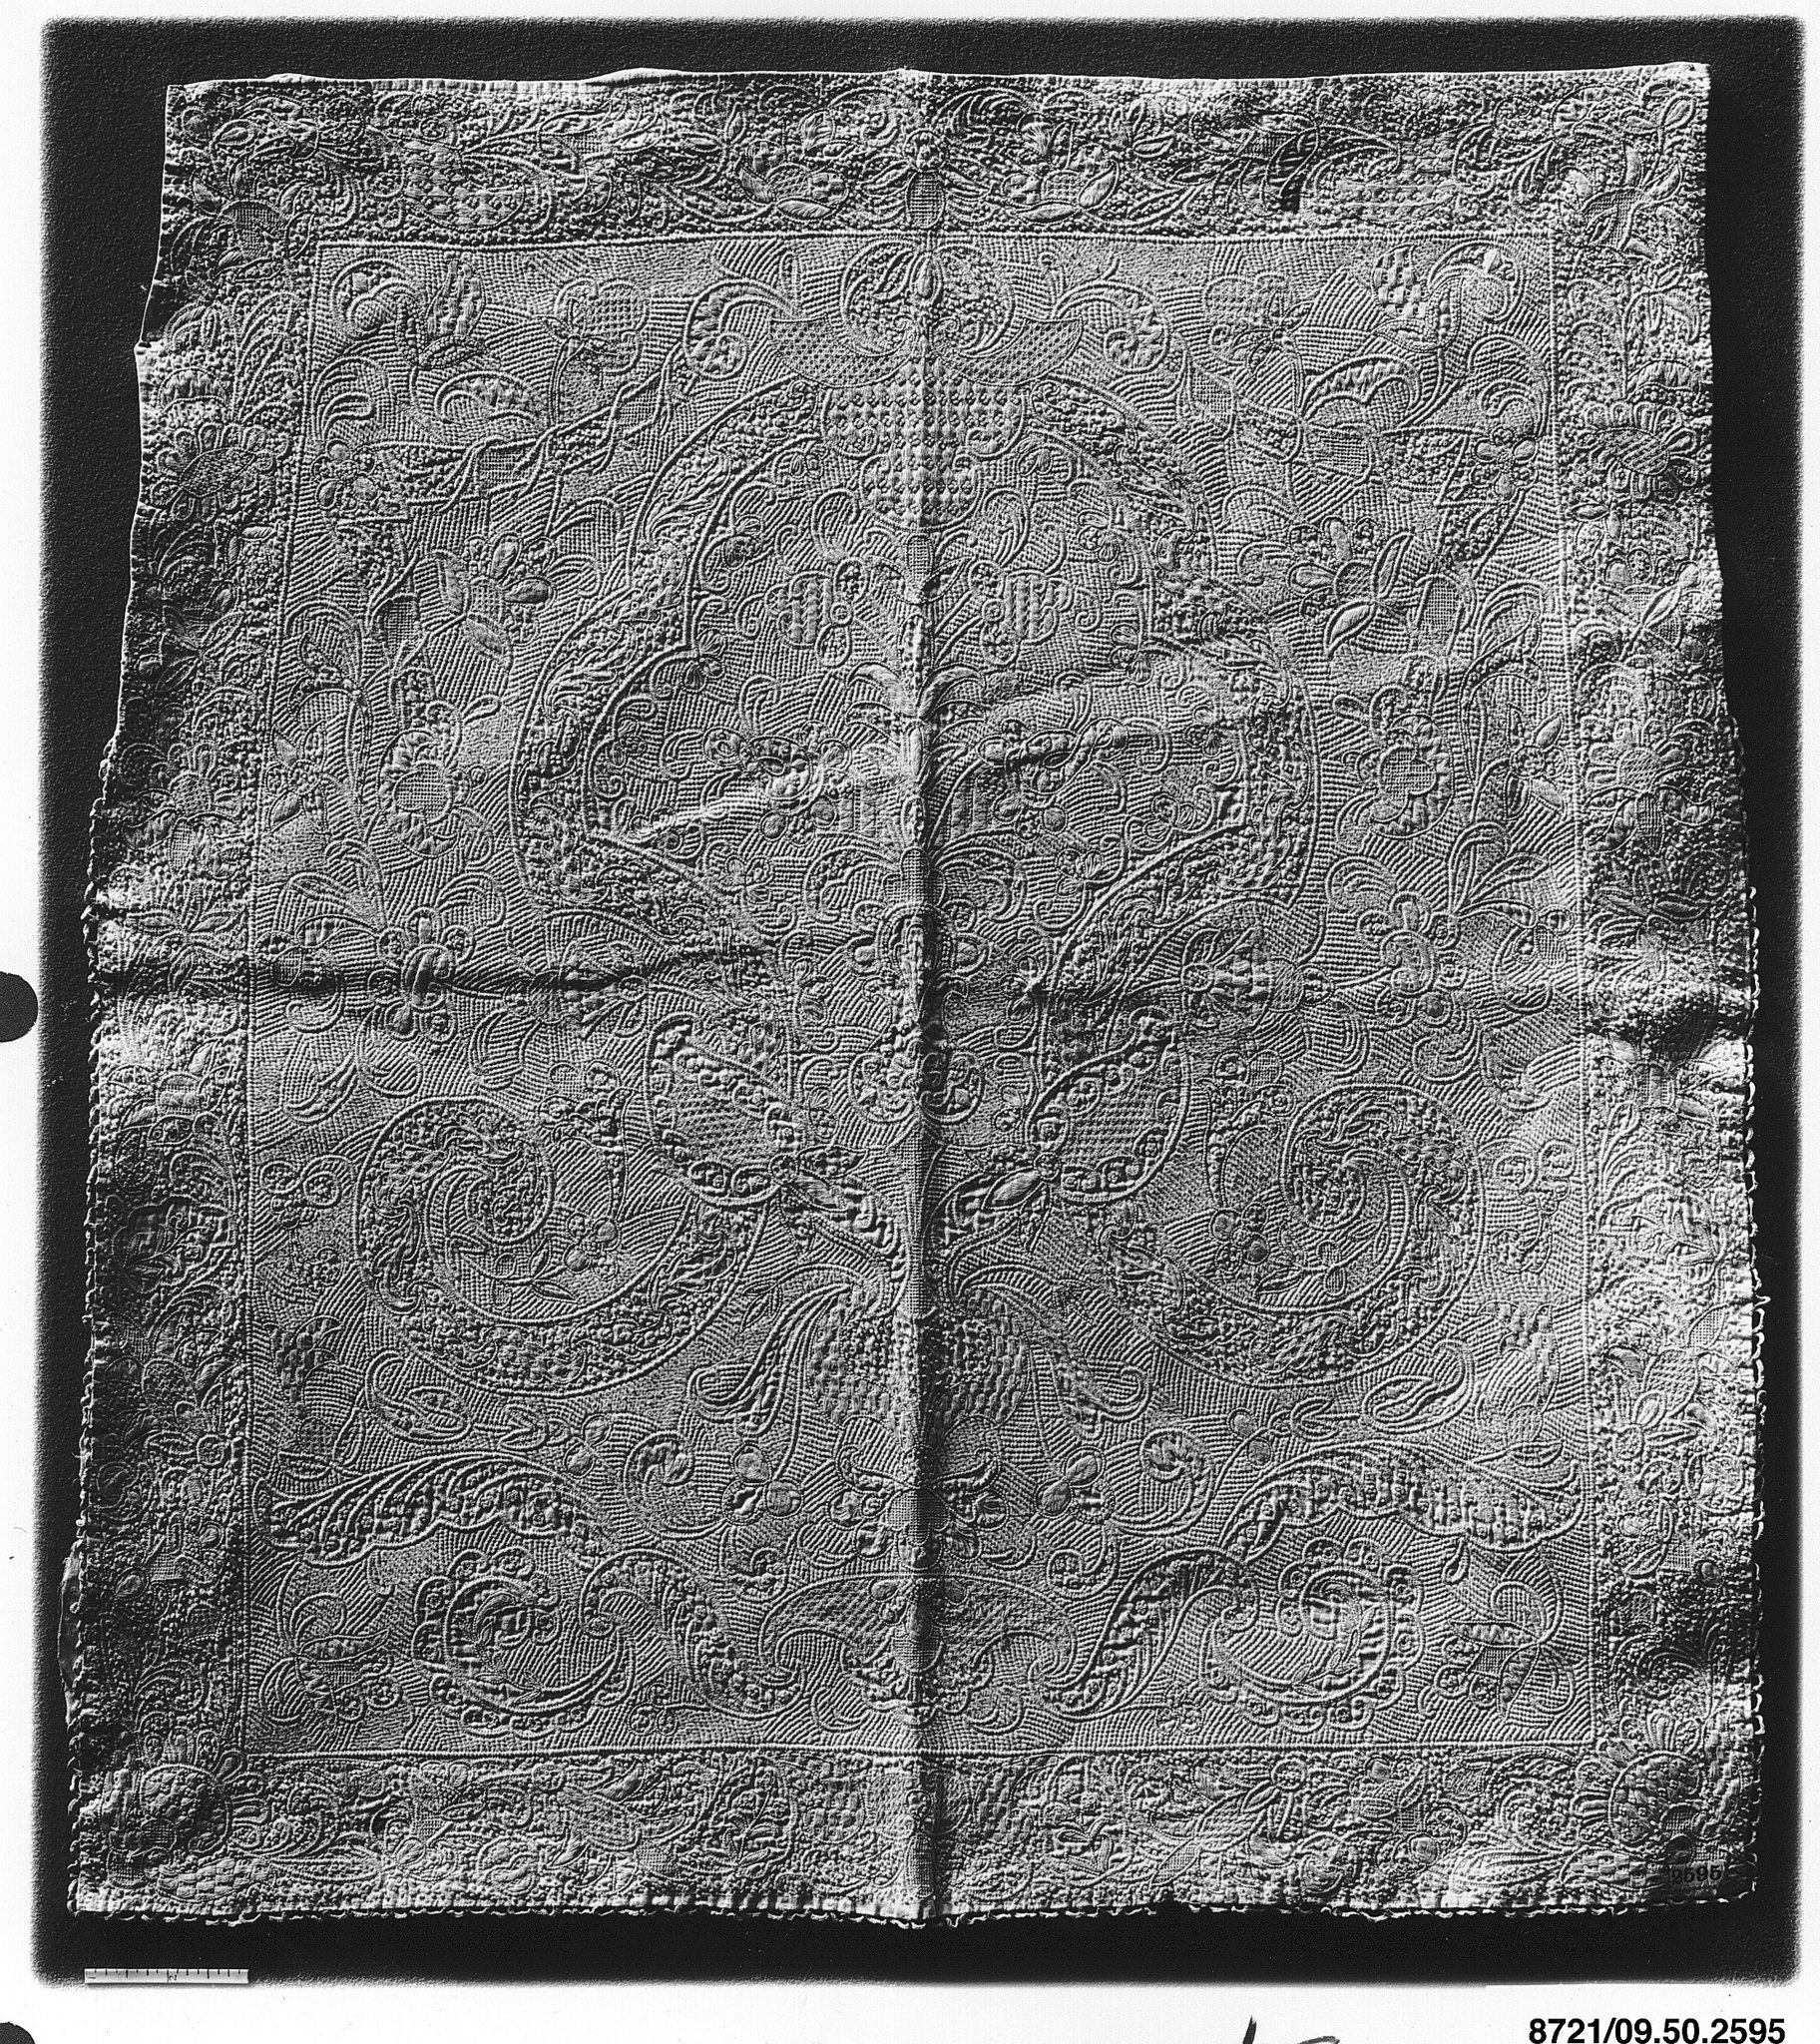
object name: cover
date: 1701-1800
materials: cotton, linen